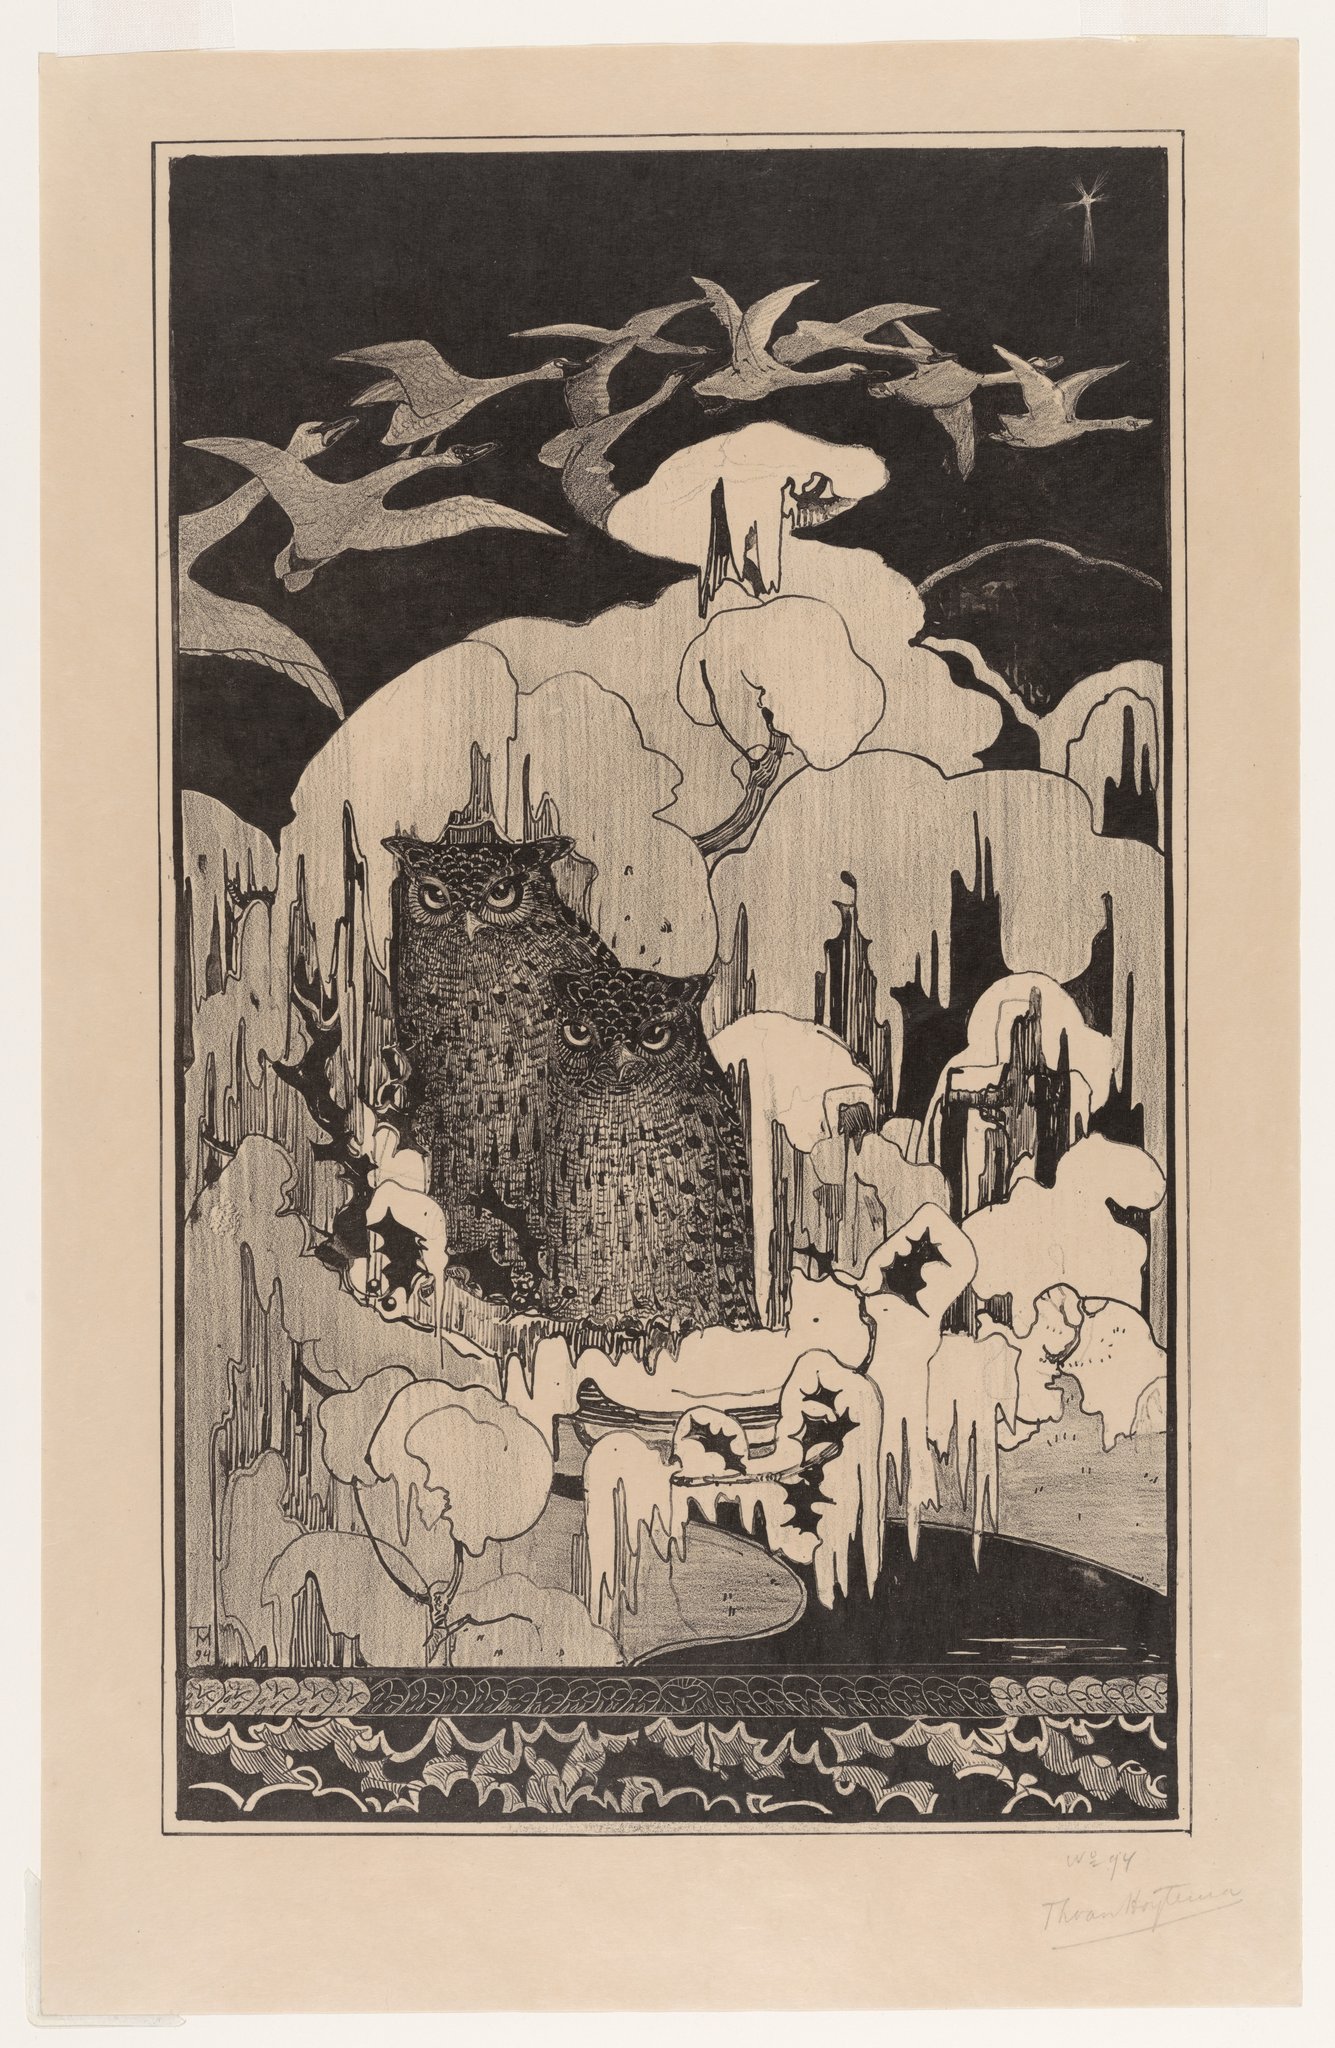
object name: print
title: Christmas Eve (Kerstnacht)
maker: theodorus van hoytema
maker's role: artist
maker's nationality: dutch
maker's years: 1863-1917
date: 1894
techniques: lithograph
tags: birds,owls,peacocks,swans